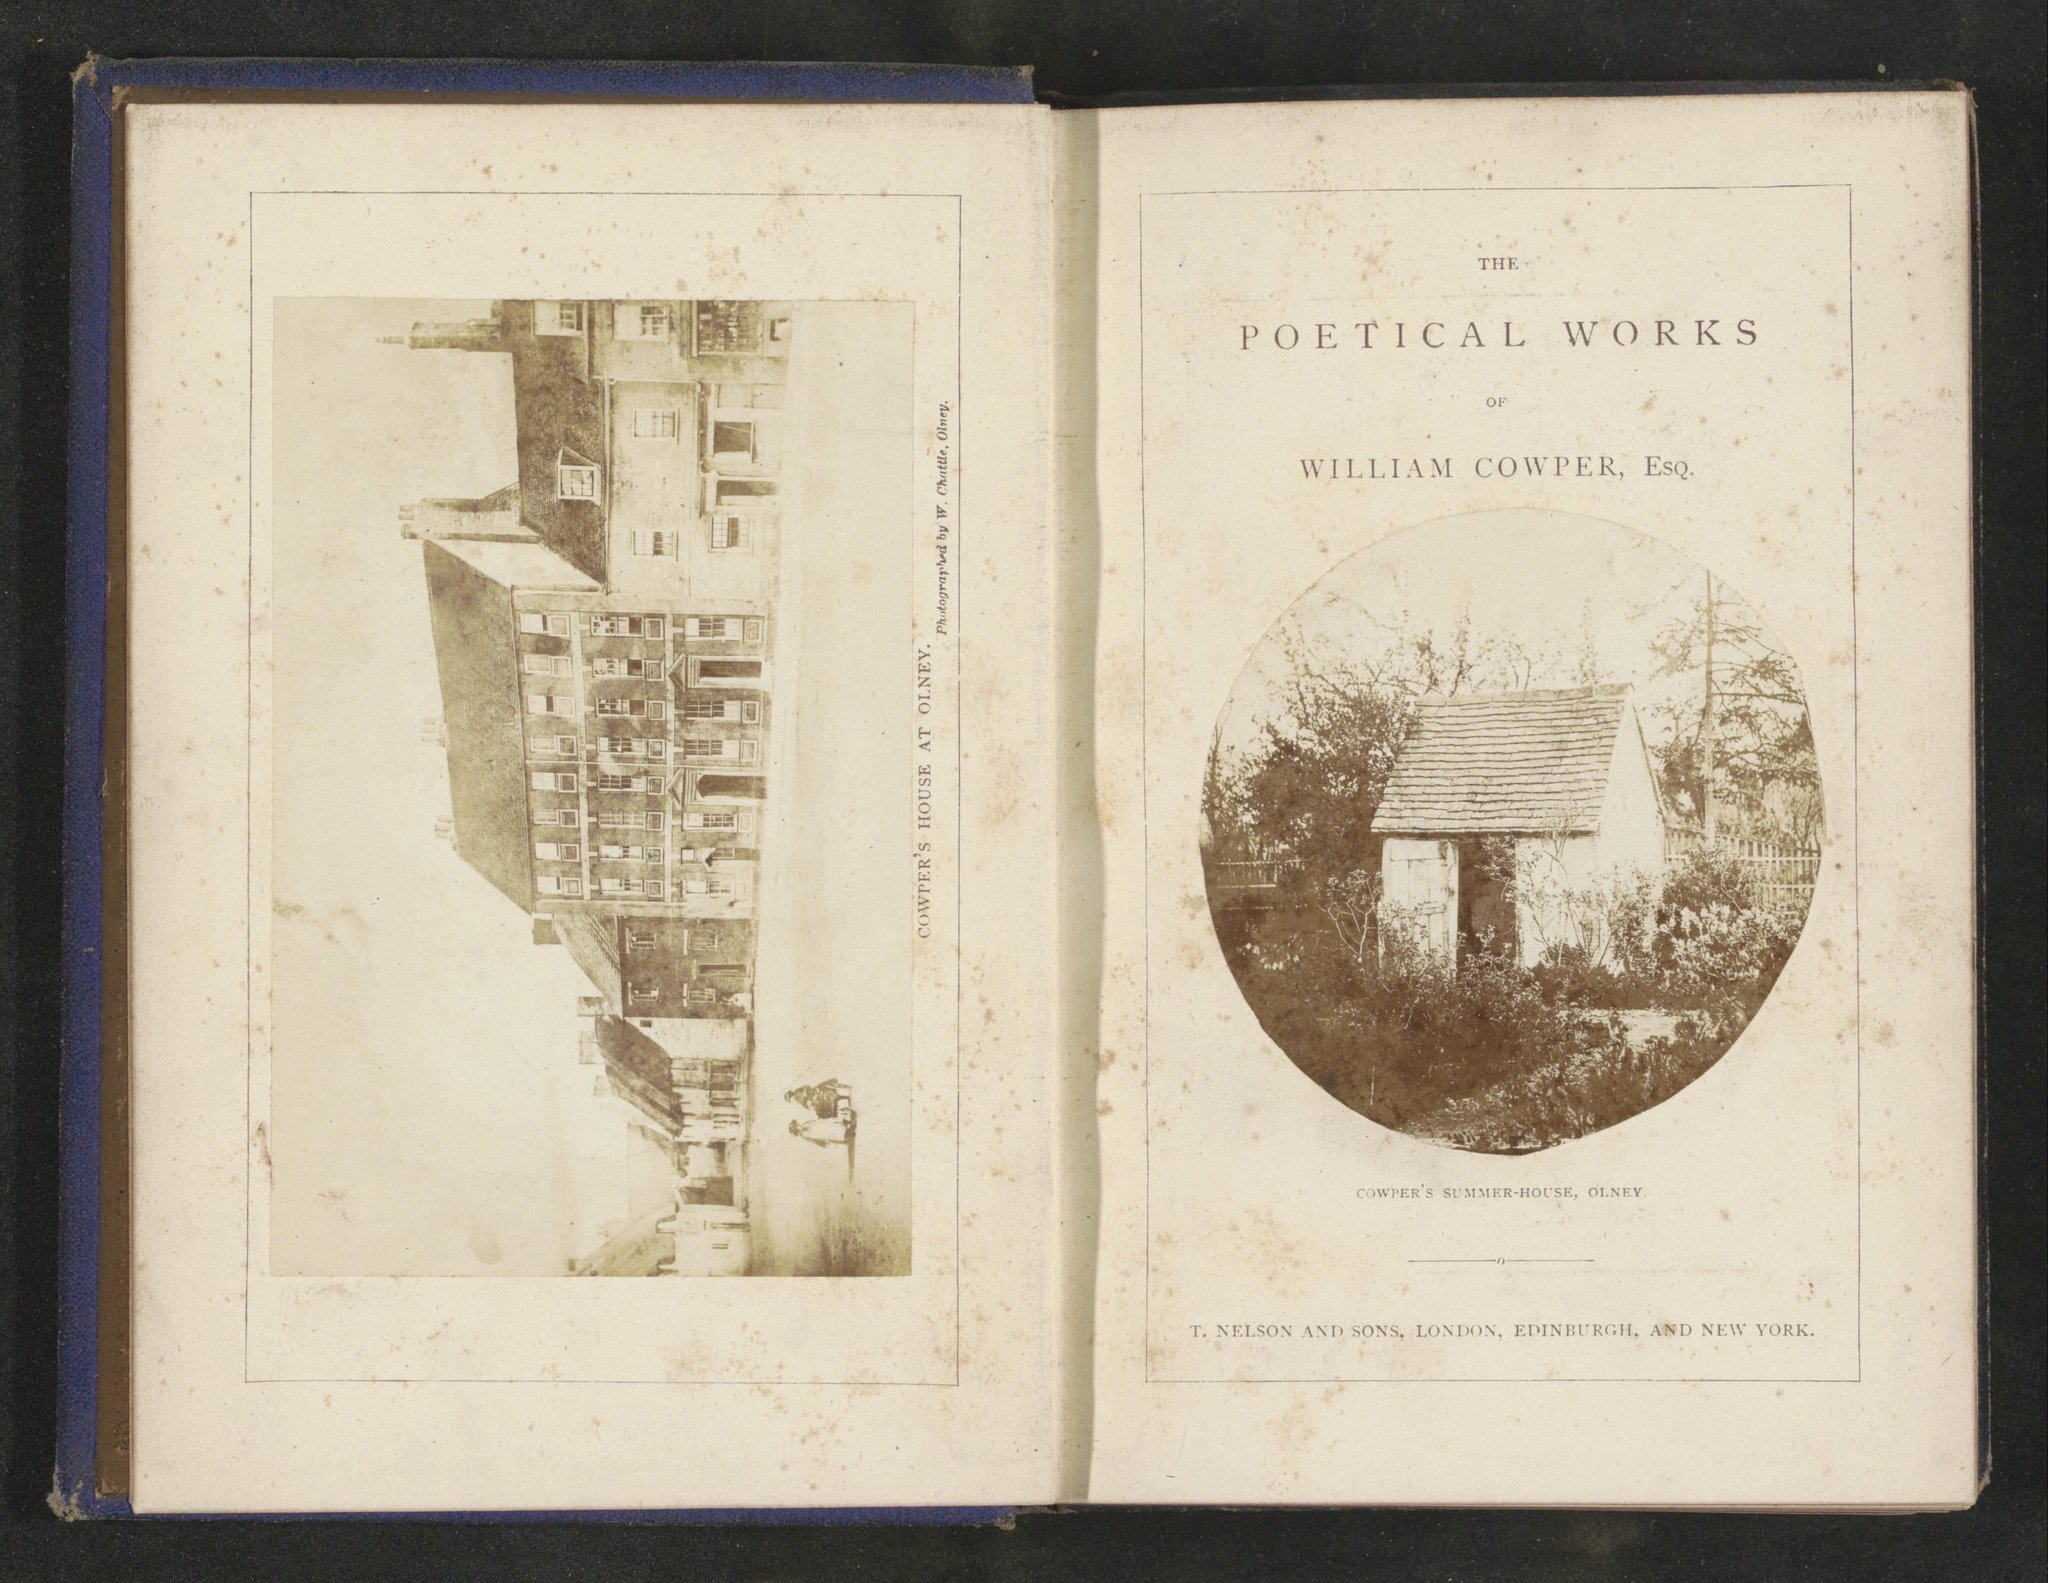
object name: book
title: The poetical works of William Cowper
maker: william cowper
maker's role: dichter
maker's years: 1731-1800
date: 1864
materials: cardboard, linen, paper, photographic support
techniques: albumen print, engraving, printing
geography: london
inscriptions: inscription: ‘ex libris SFJ’, inscription: ‘To M. F. Atkinson from her two friends M. L. B. & S. R. 1865’